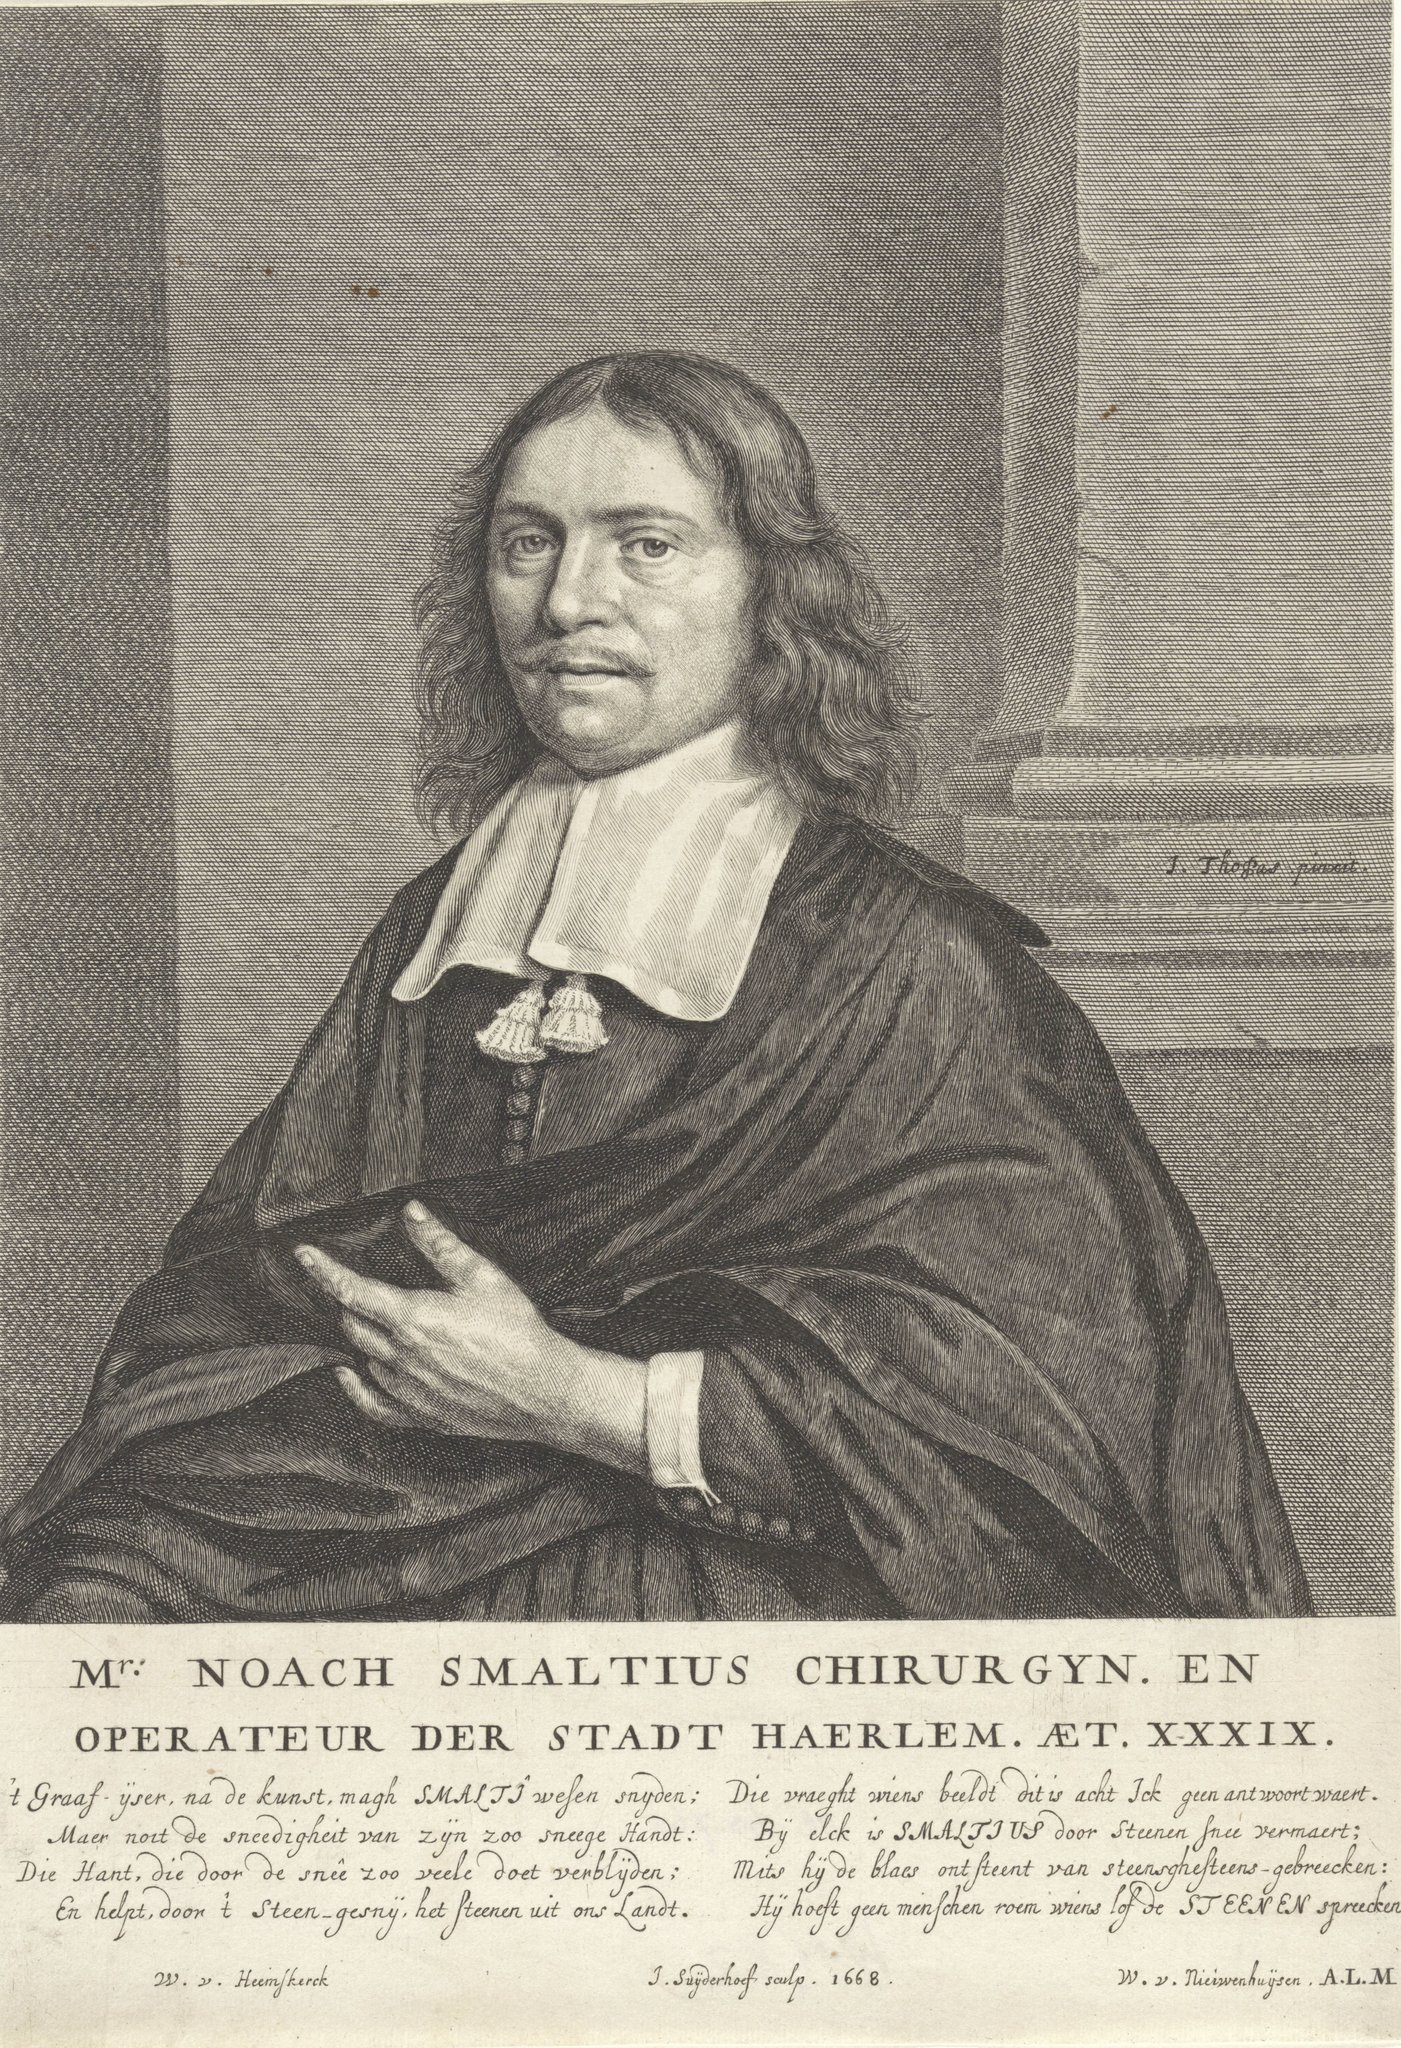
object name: print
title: Portret van Noach Smaltius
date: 1668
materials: paper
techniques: engraving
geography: haarlem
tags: barber; surgeon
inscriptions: date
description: Portret van Noach Smaltius, chirurg in Haarlem, op 39-jarige leeftijd. Onder het portret zijn naam, functie en twee vierregelige verzen in het Nederlands.